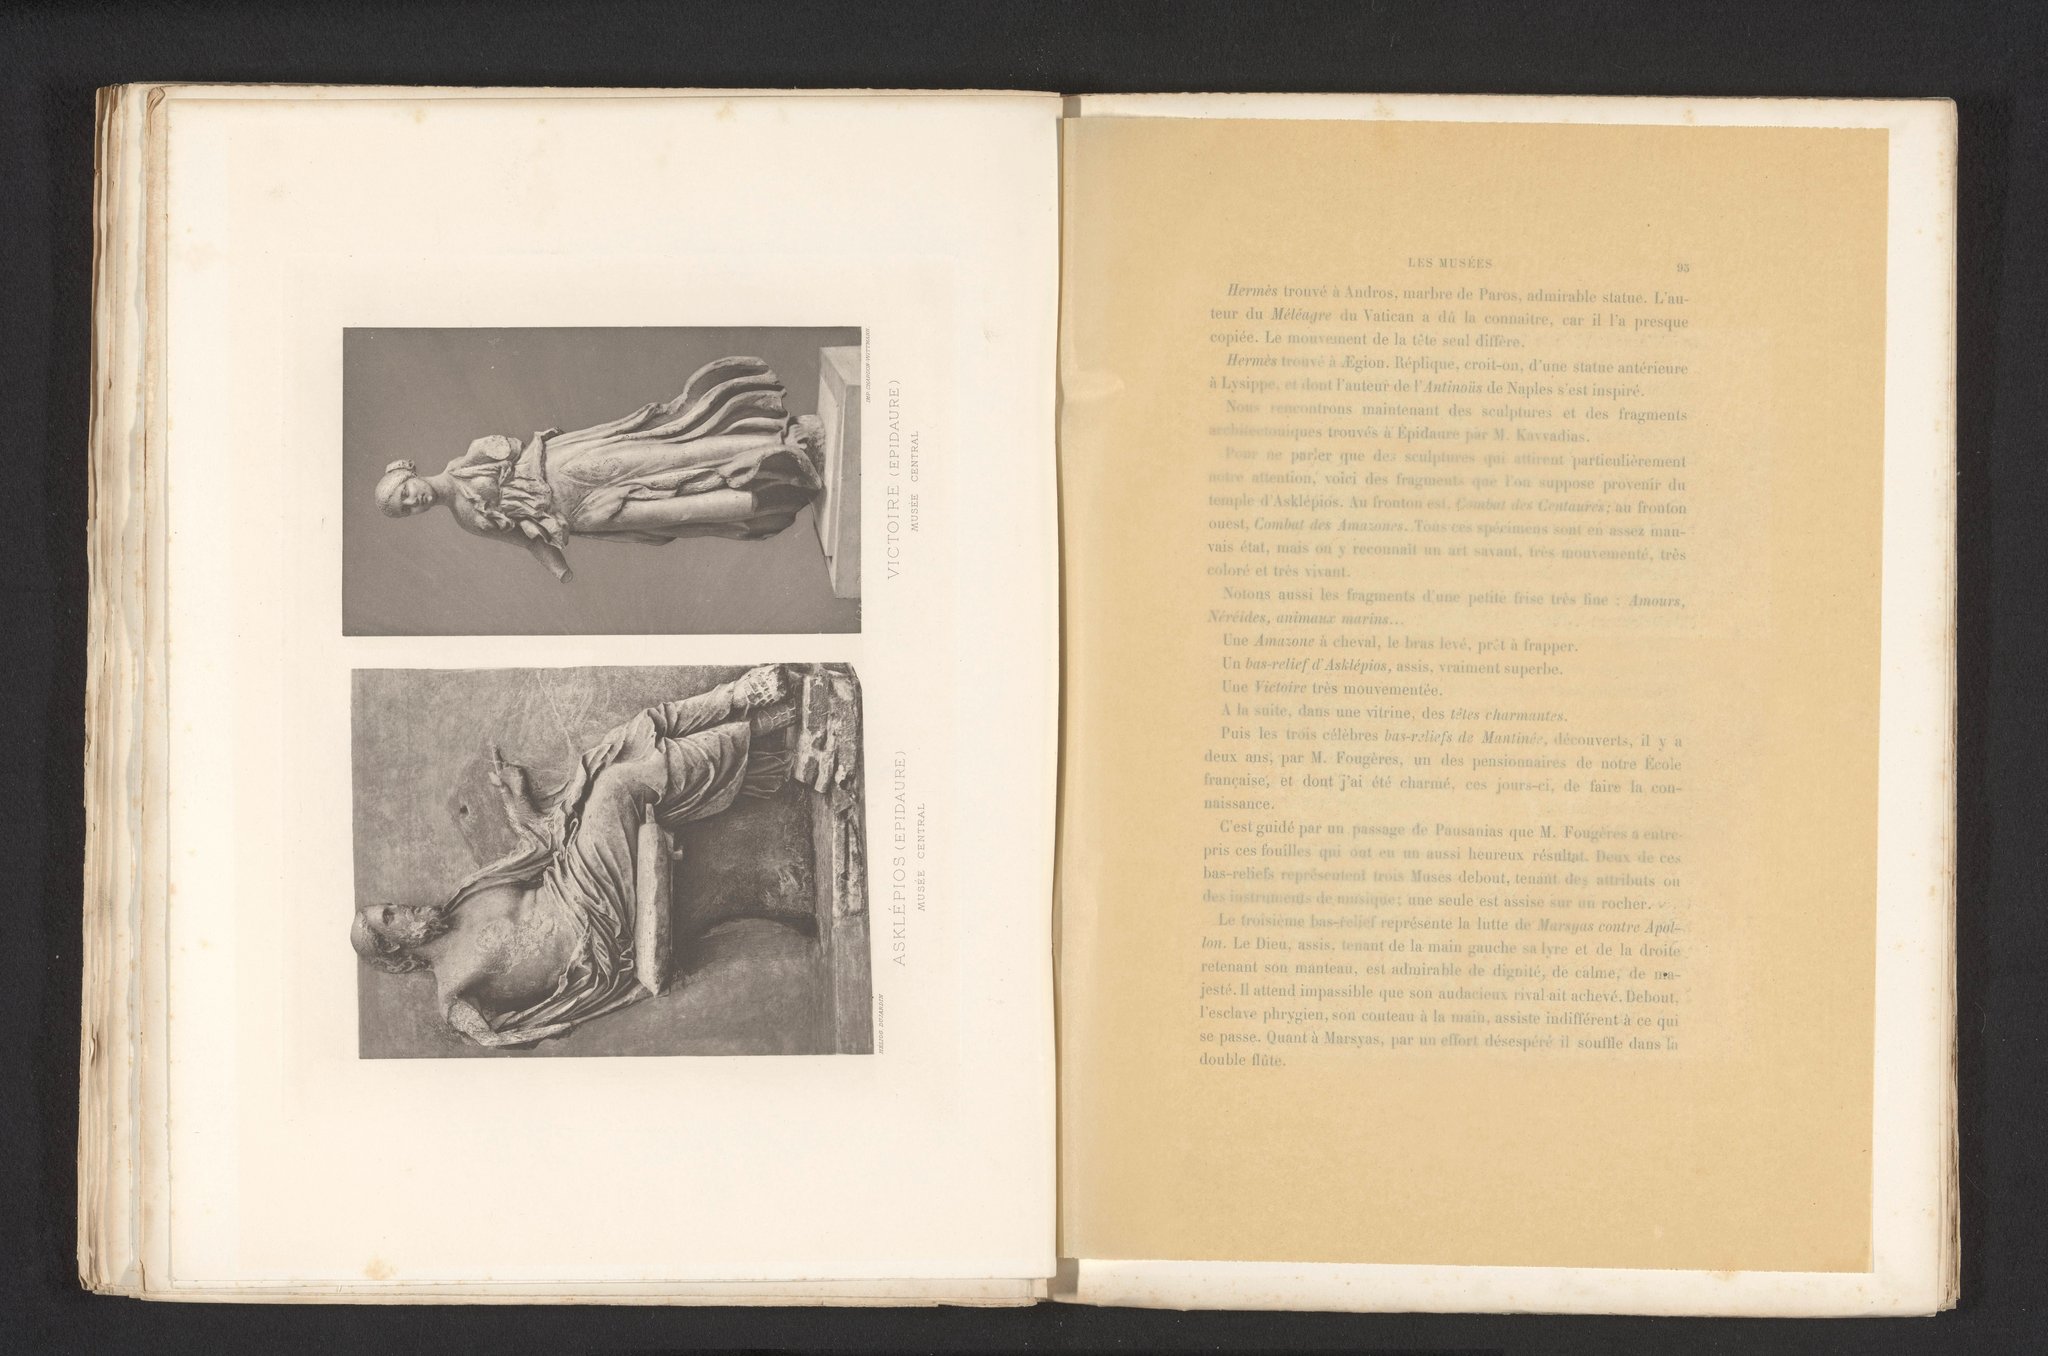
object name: page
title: Victoire (Epidaure)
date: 1880-1890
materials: paper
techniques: photoaquatint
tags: sculpture, (story of) aesculapius (asclepius), (story of) nike, sculpture (+ relief ~ sculpture)